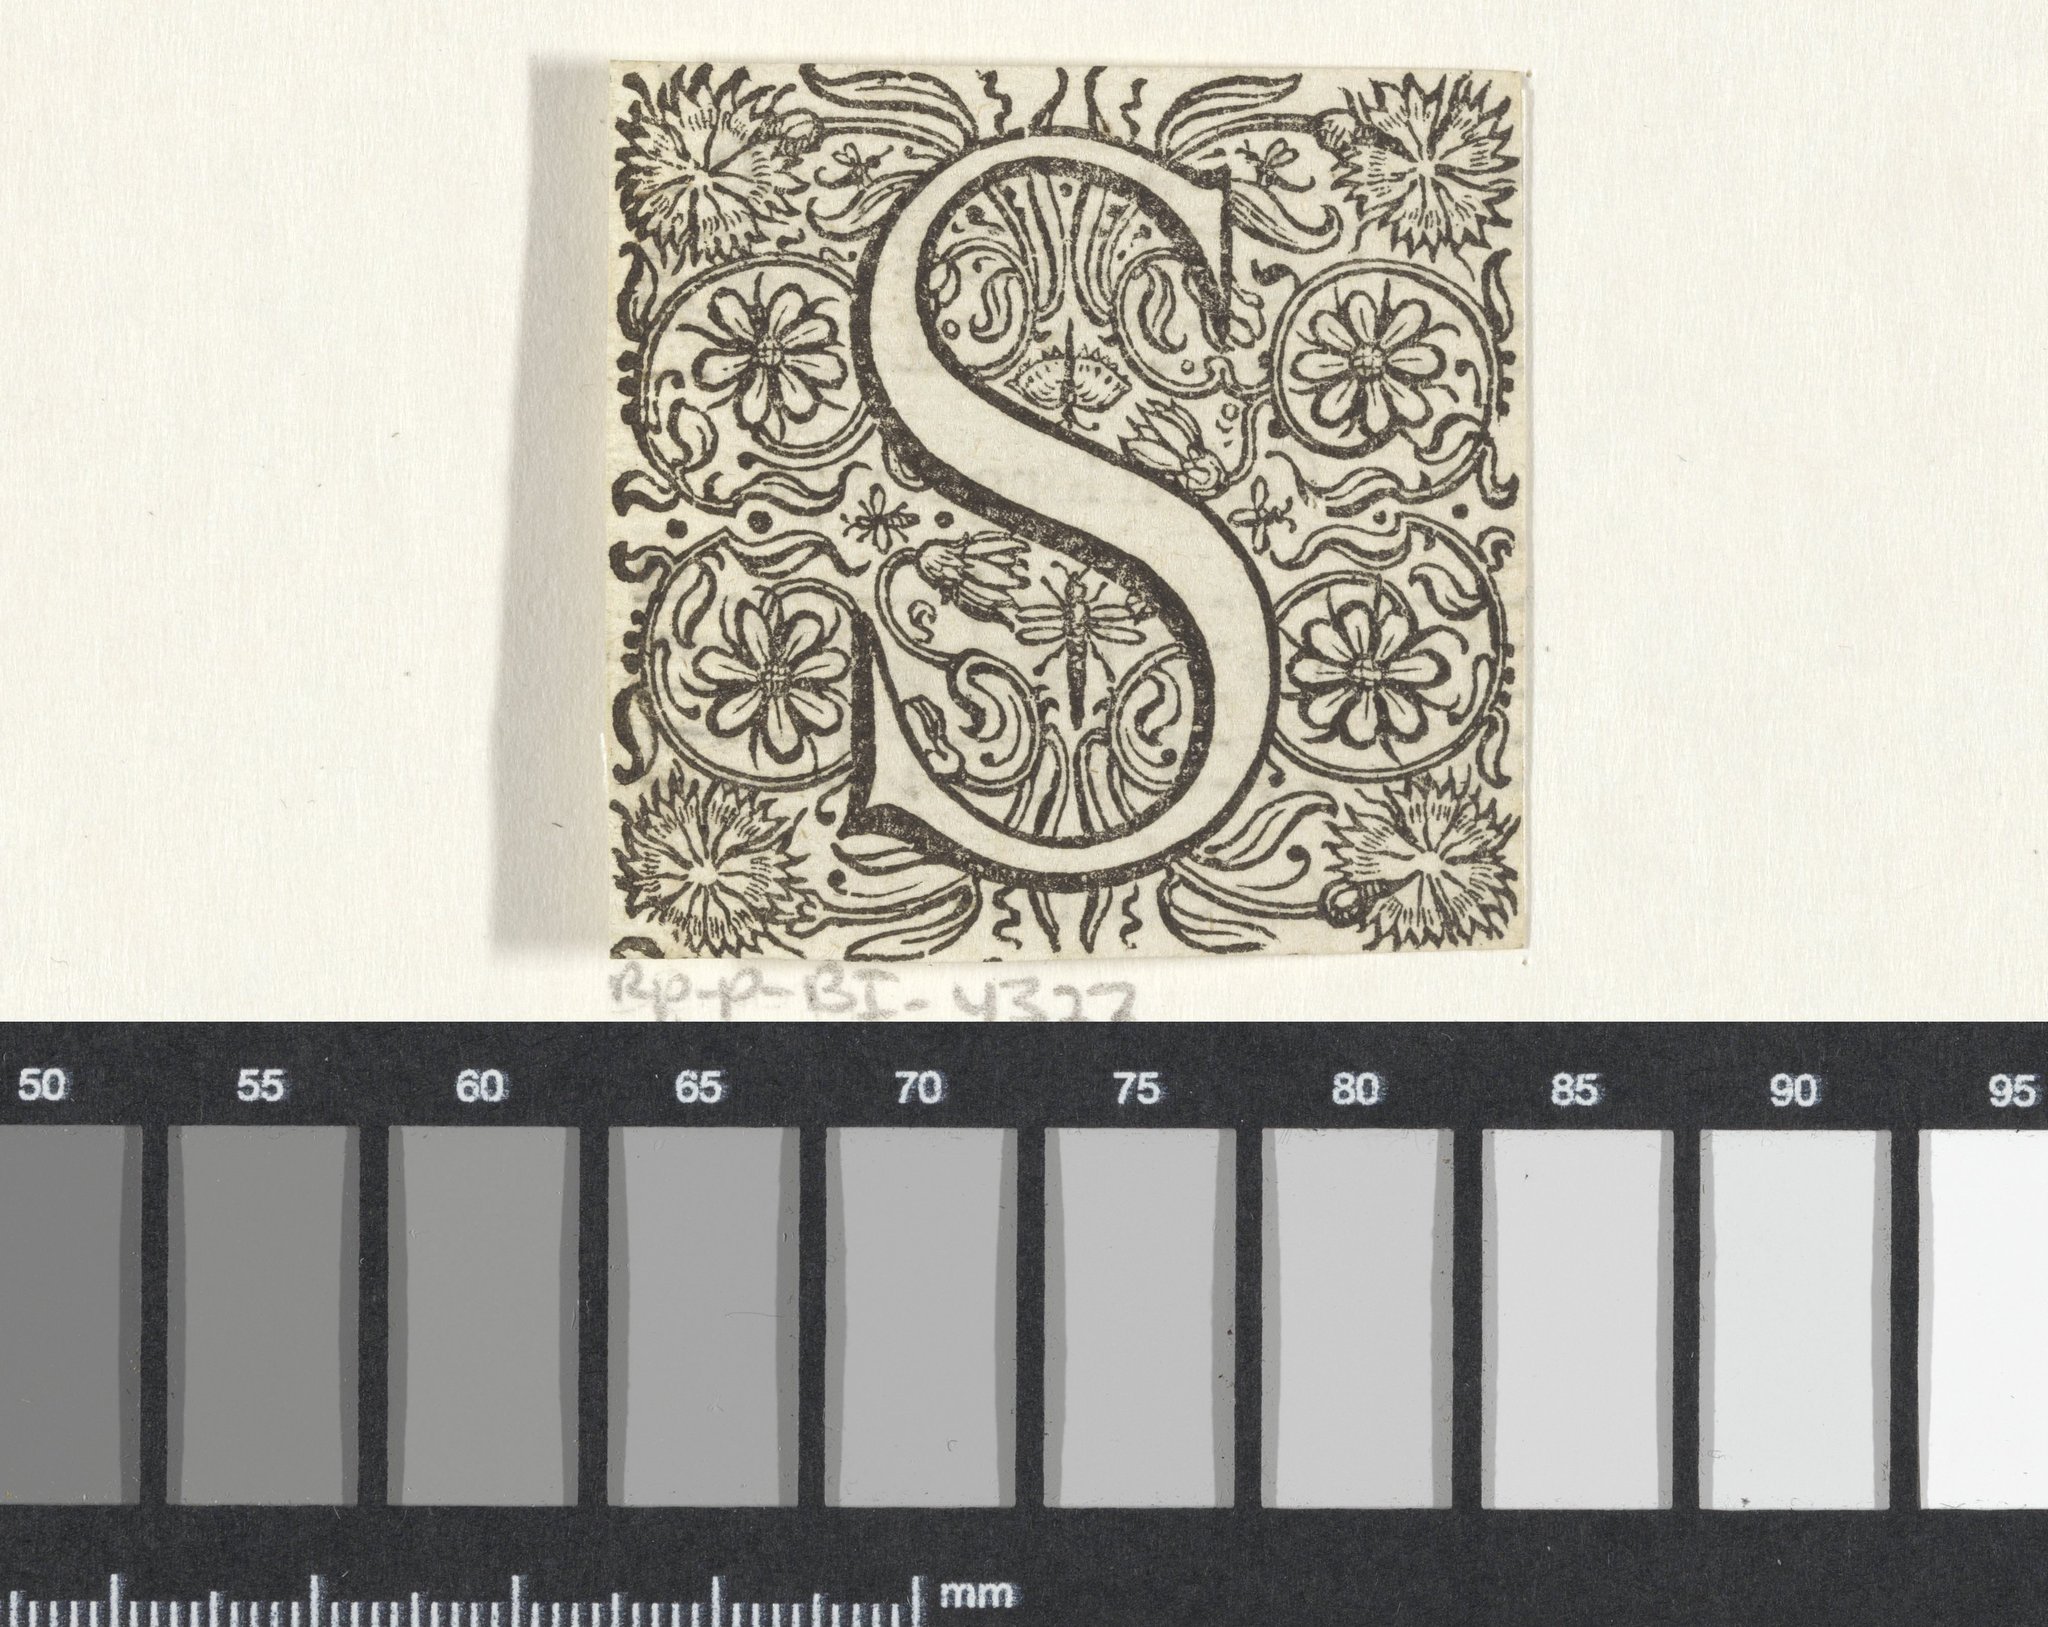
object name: print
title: Letter S in een omlijsting met bloemen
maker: Anonymous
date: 1600-1699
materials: paper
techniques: letterpress printing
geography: netherlands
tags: flowers, fancy letters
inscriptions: collector's mark: Lugt 240